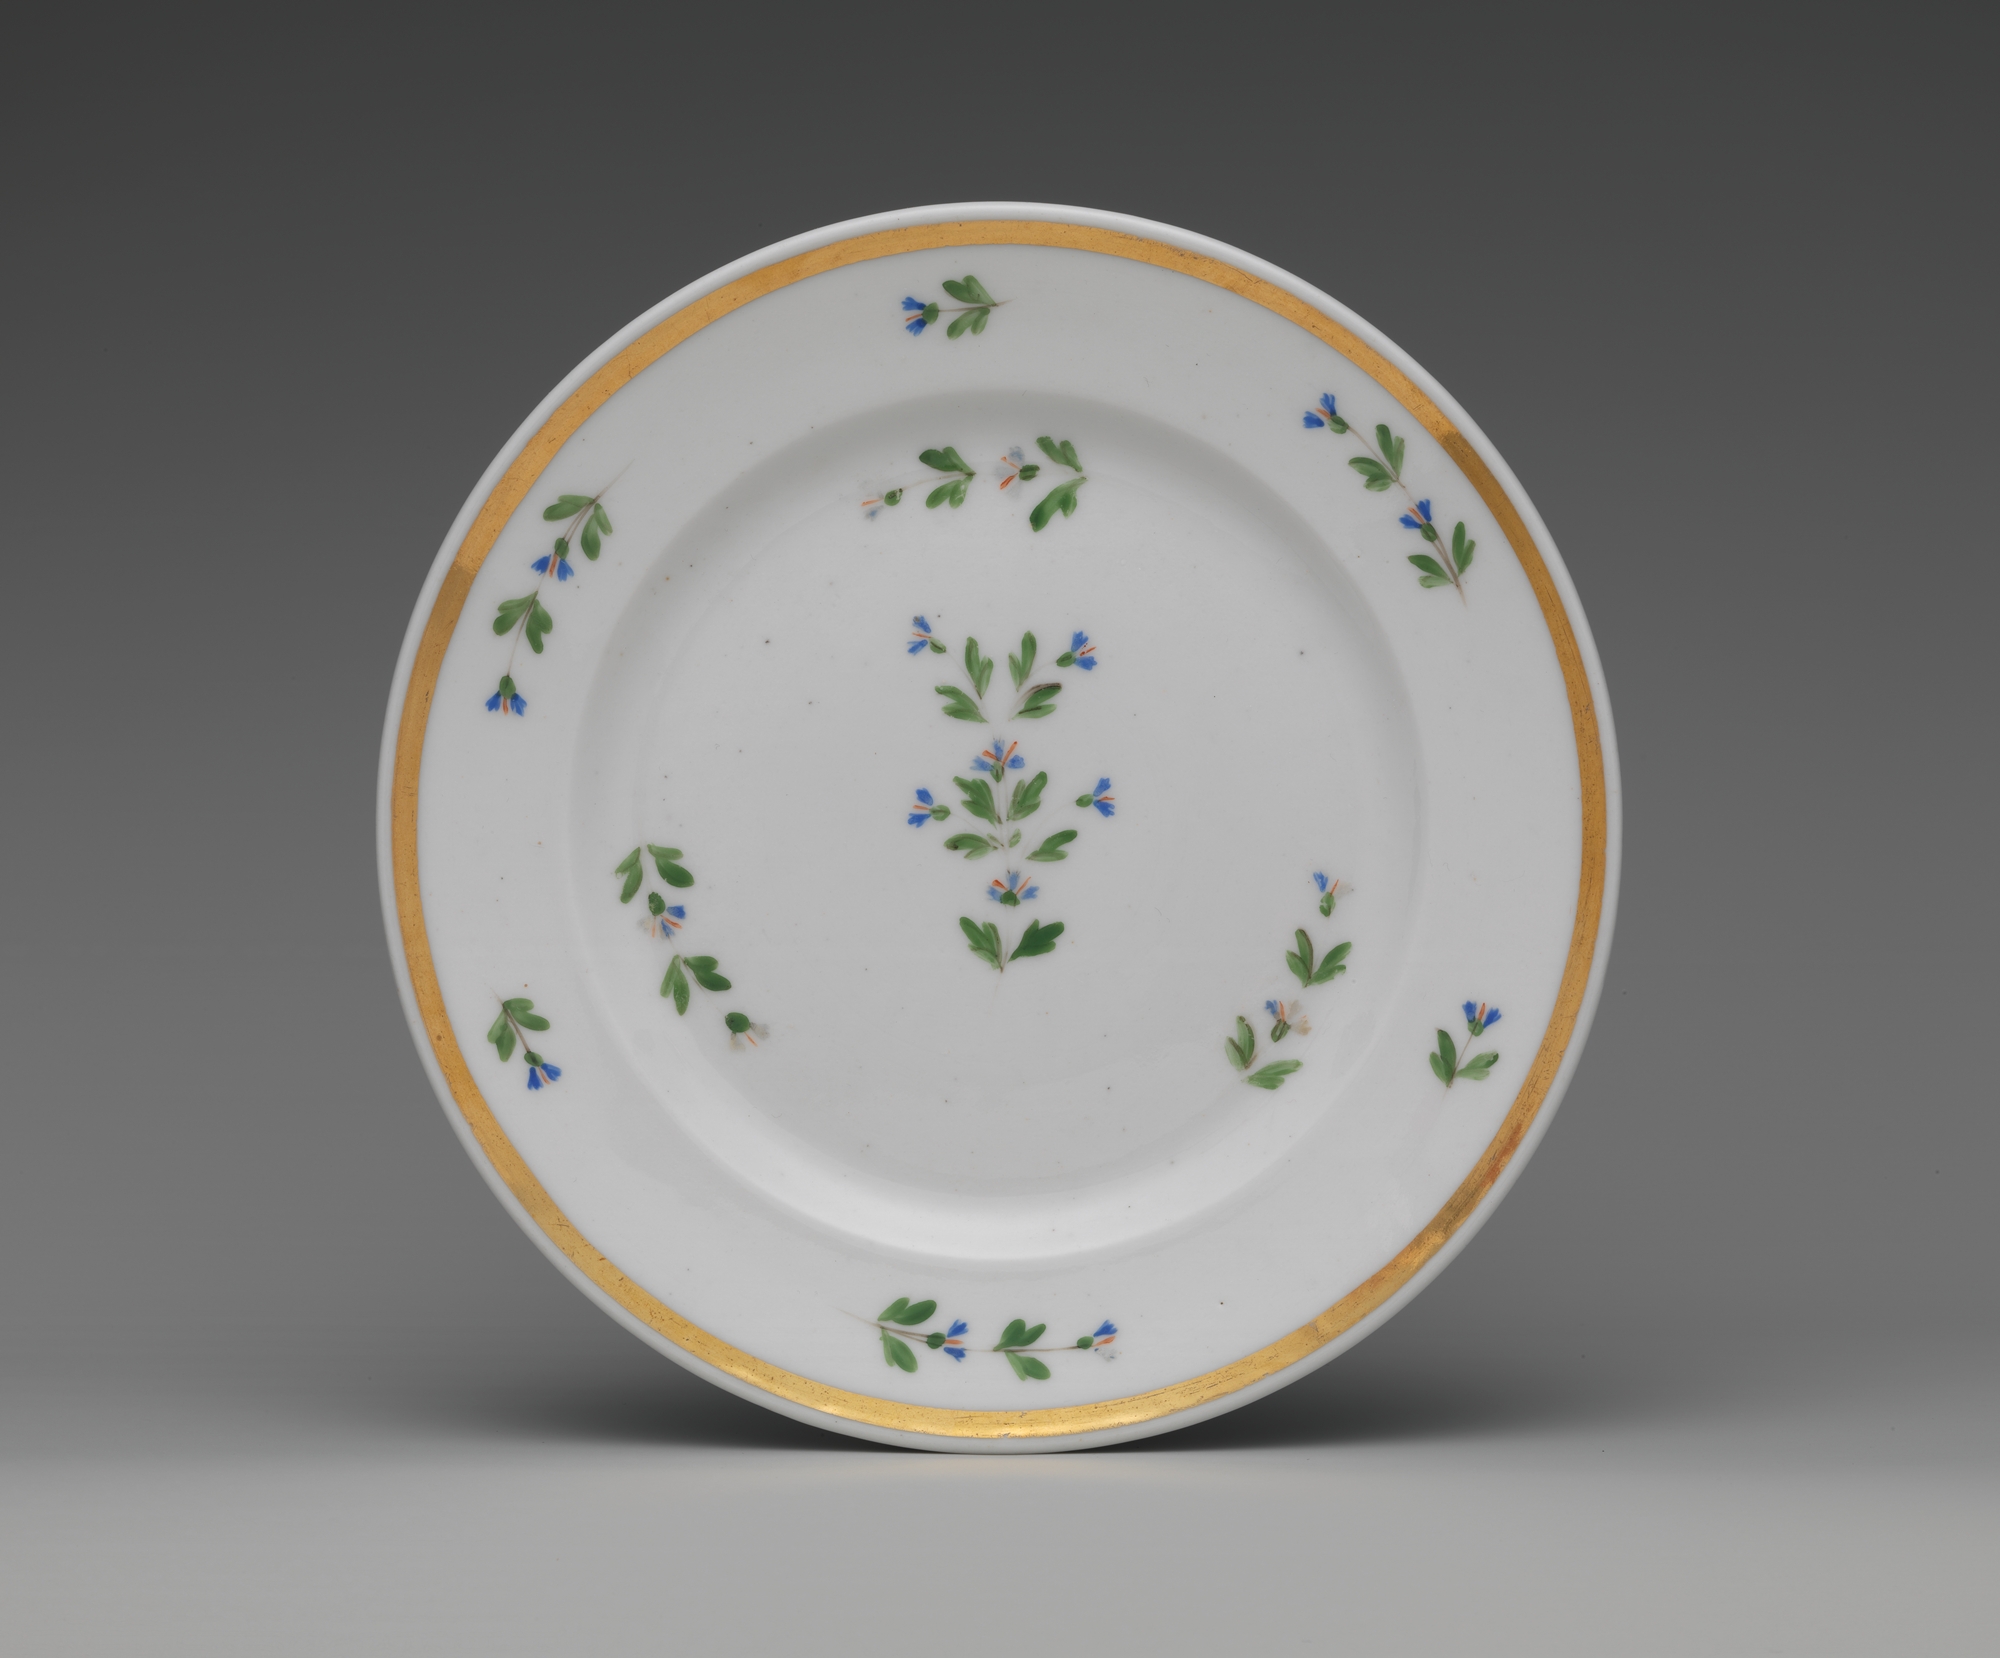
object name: plate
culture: french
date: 1815-1830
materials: porcelain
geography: france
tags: flowers